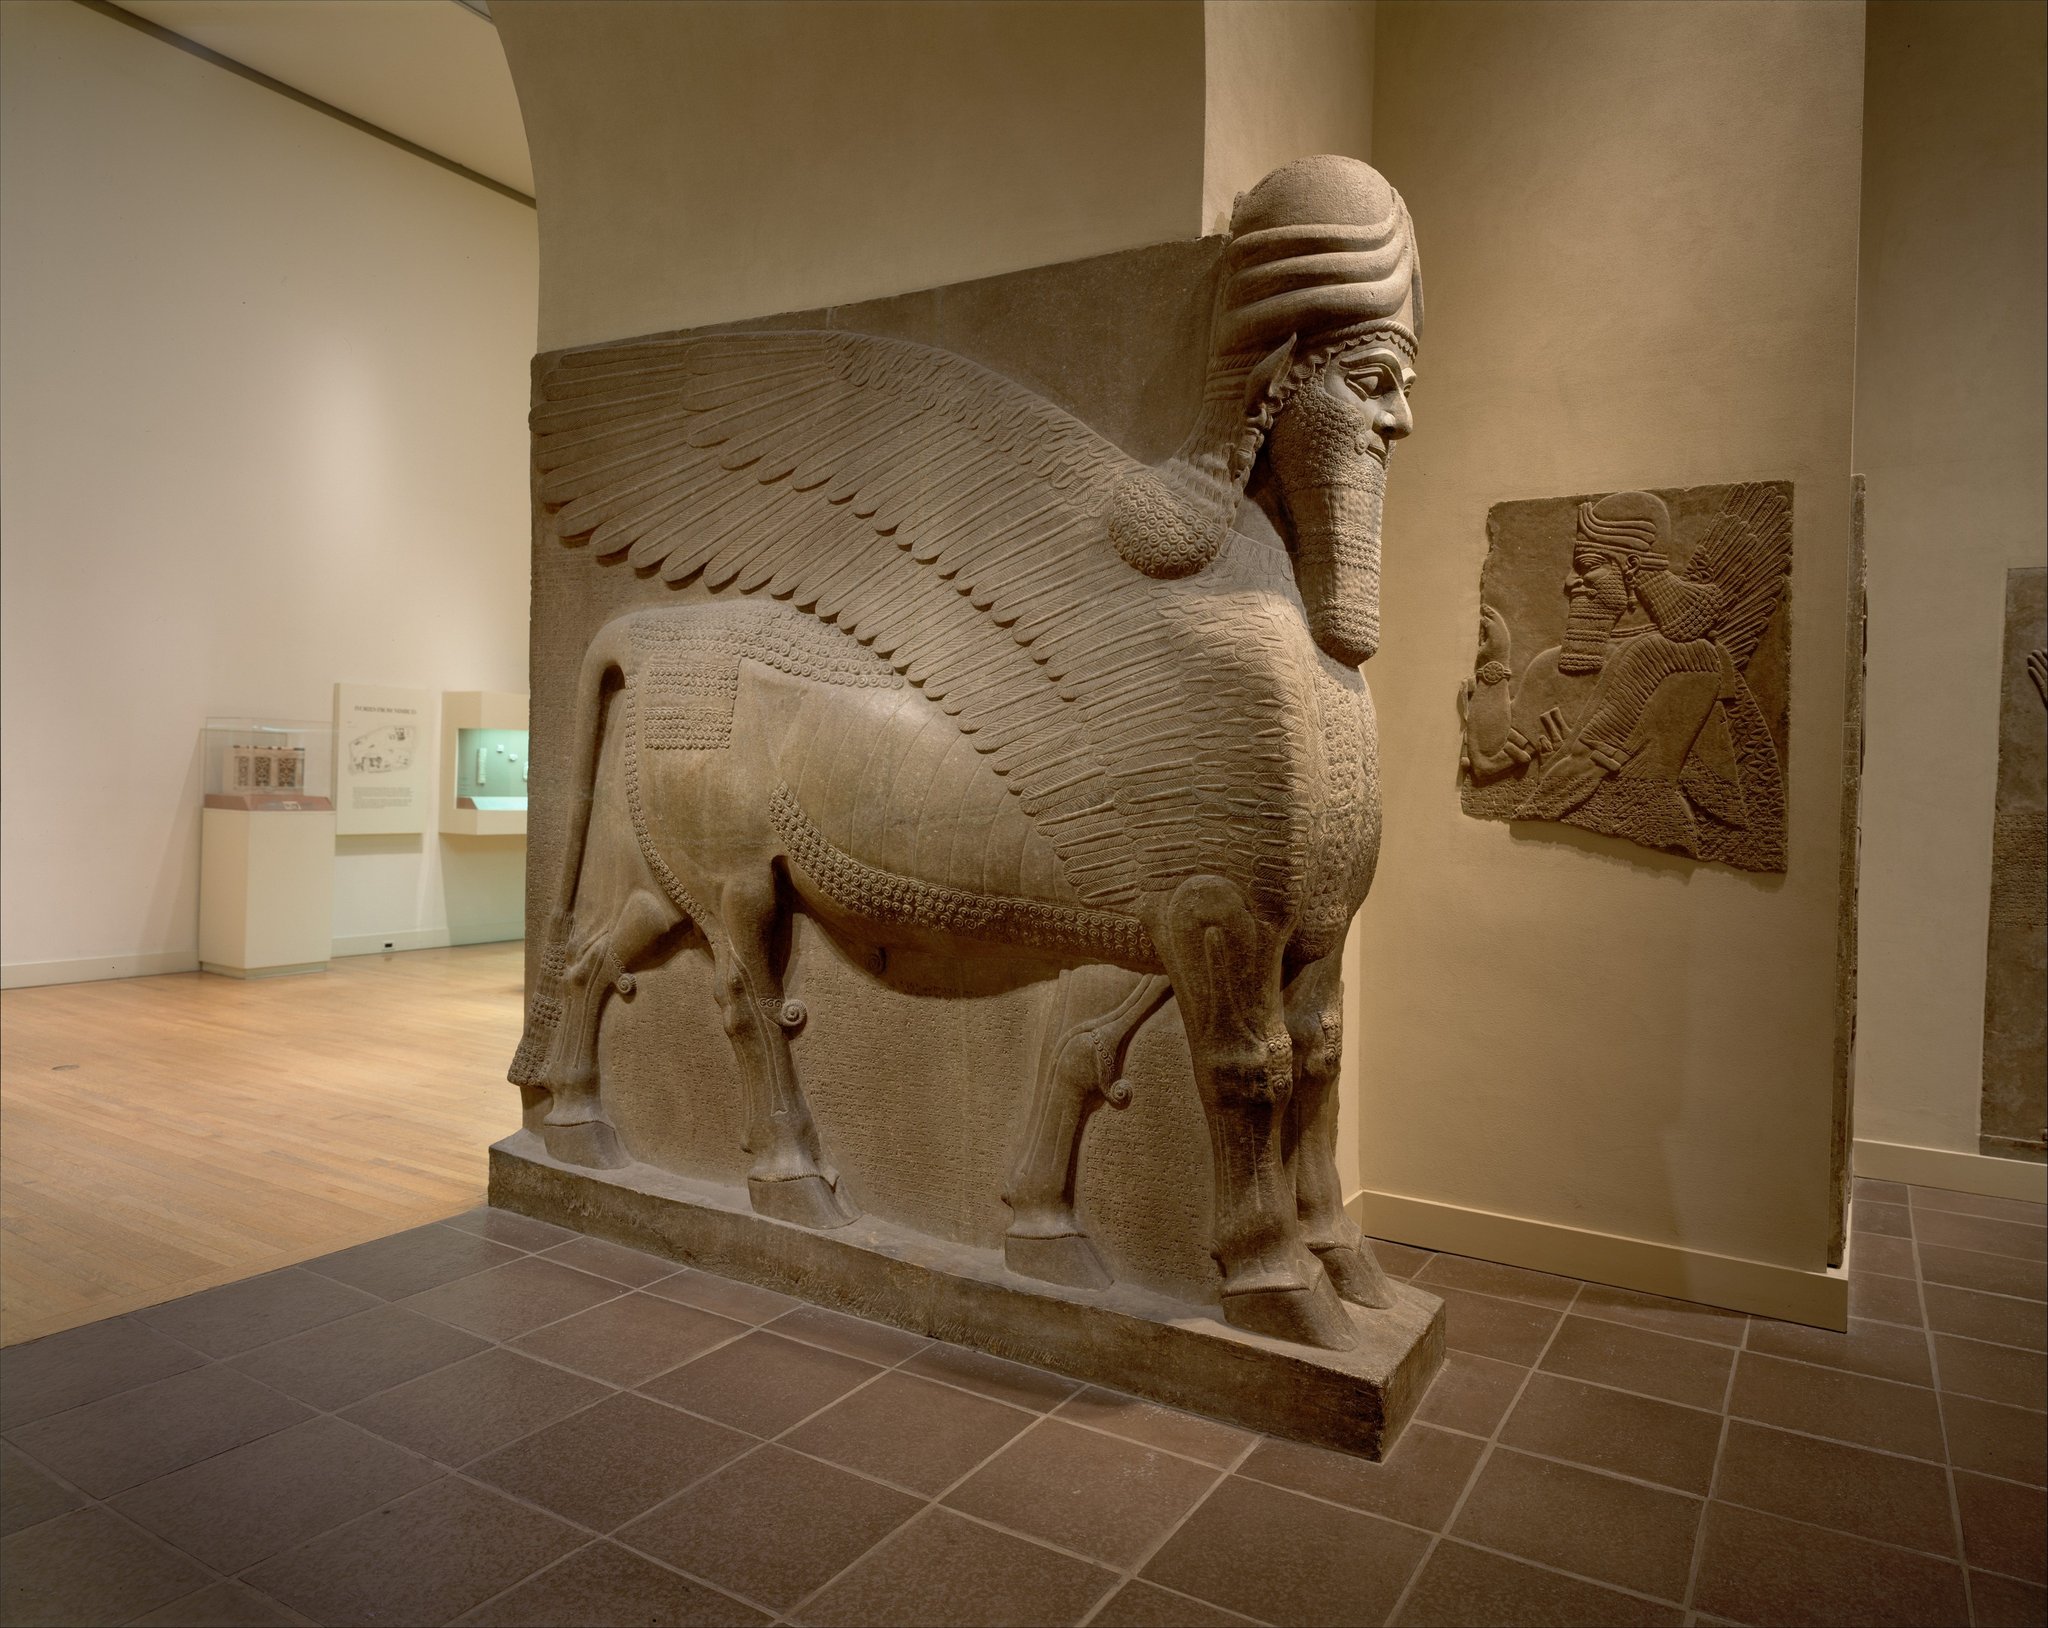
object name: relief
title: Human-headed winged bull (lamassu)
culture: assyrian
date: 883-859 BCE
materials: alabaster, gypsum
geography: mesopotamia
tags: bulls